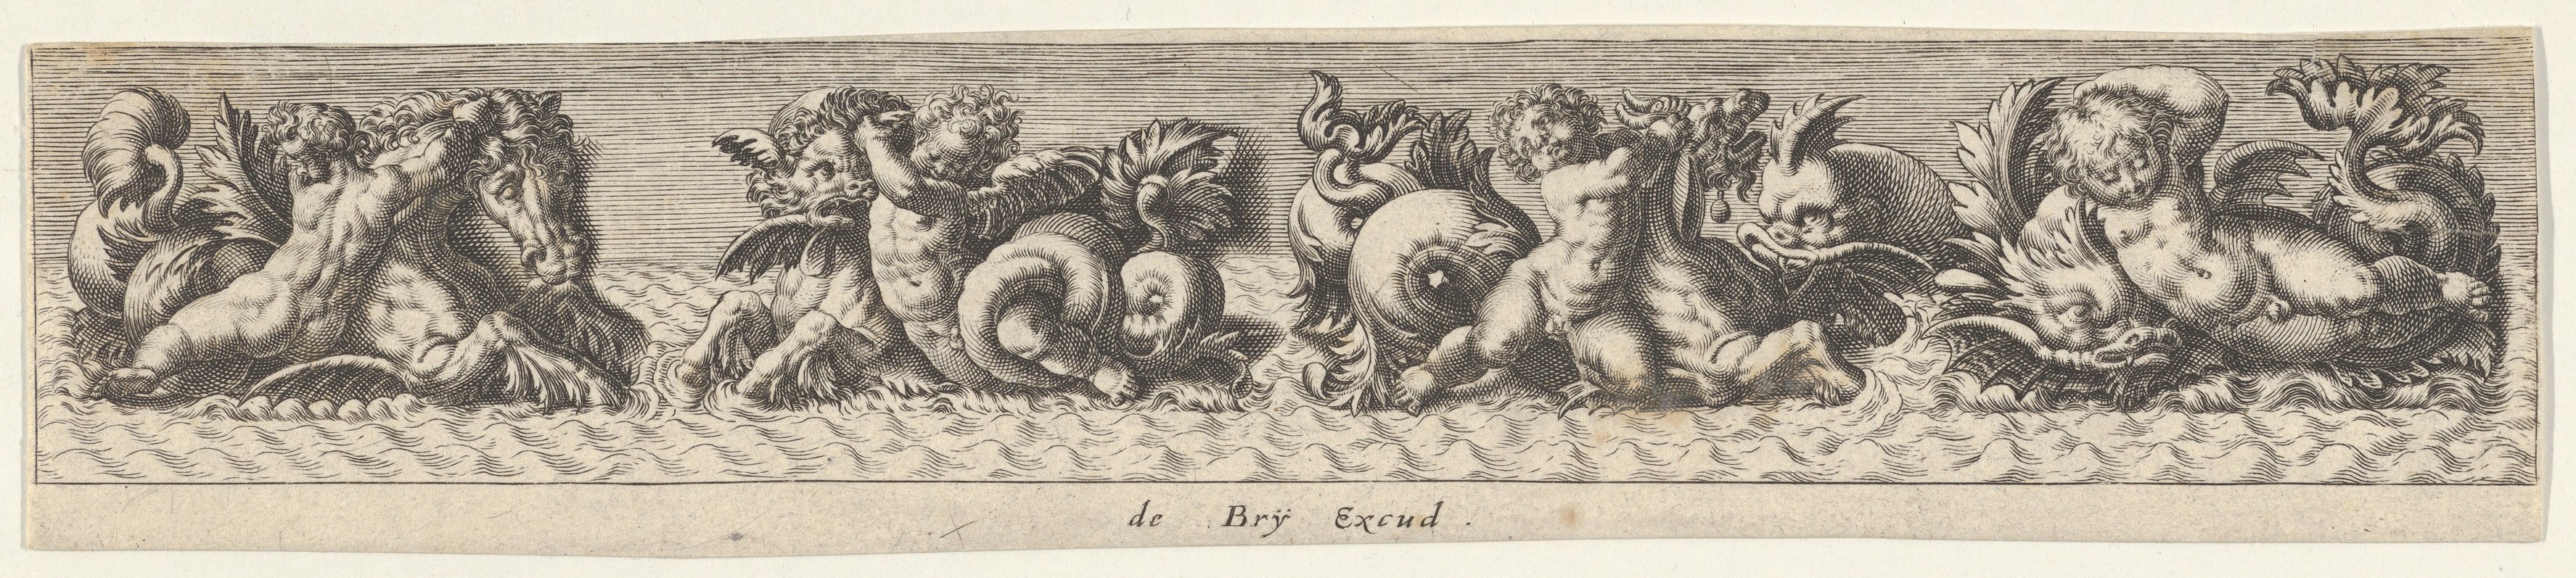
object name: print ornament architecture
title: Frieze with Sea Monsters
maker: johann theodor de bry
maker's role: artist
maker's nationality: netherlandish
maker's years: 1561-1623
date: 1580-1600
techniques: engraving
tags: mythical creatures,putti